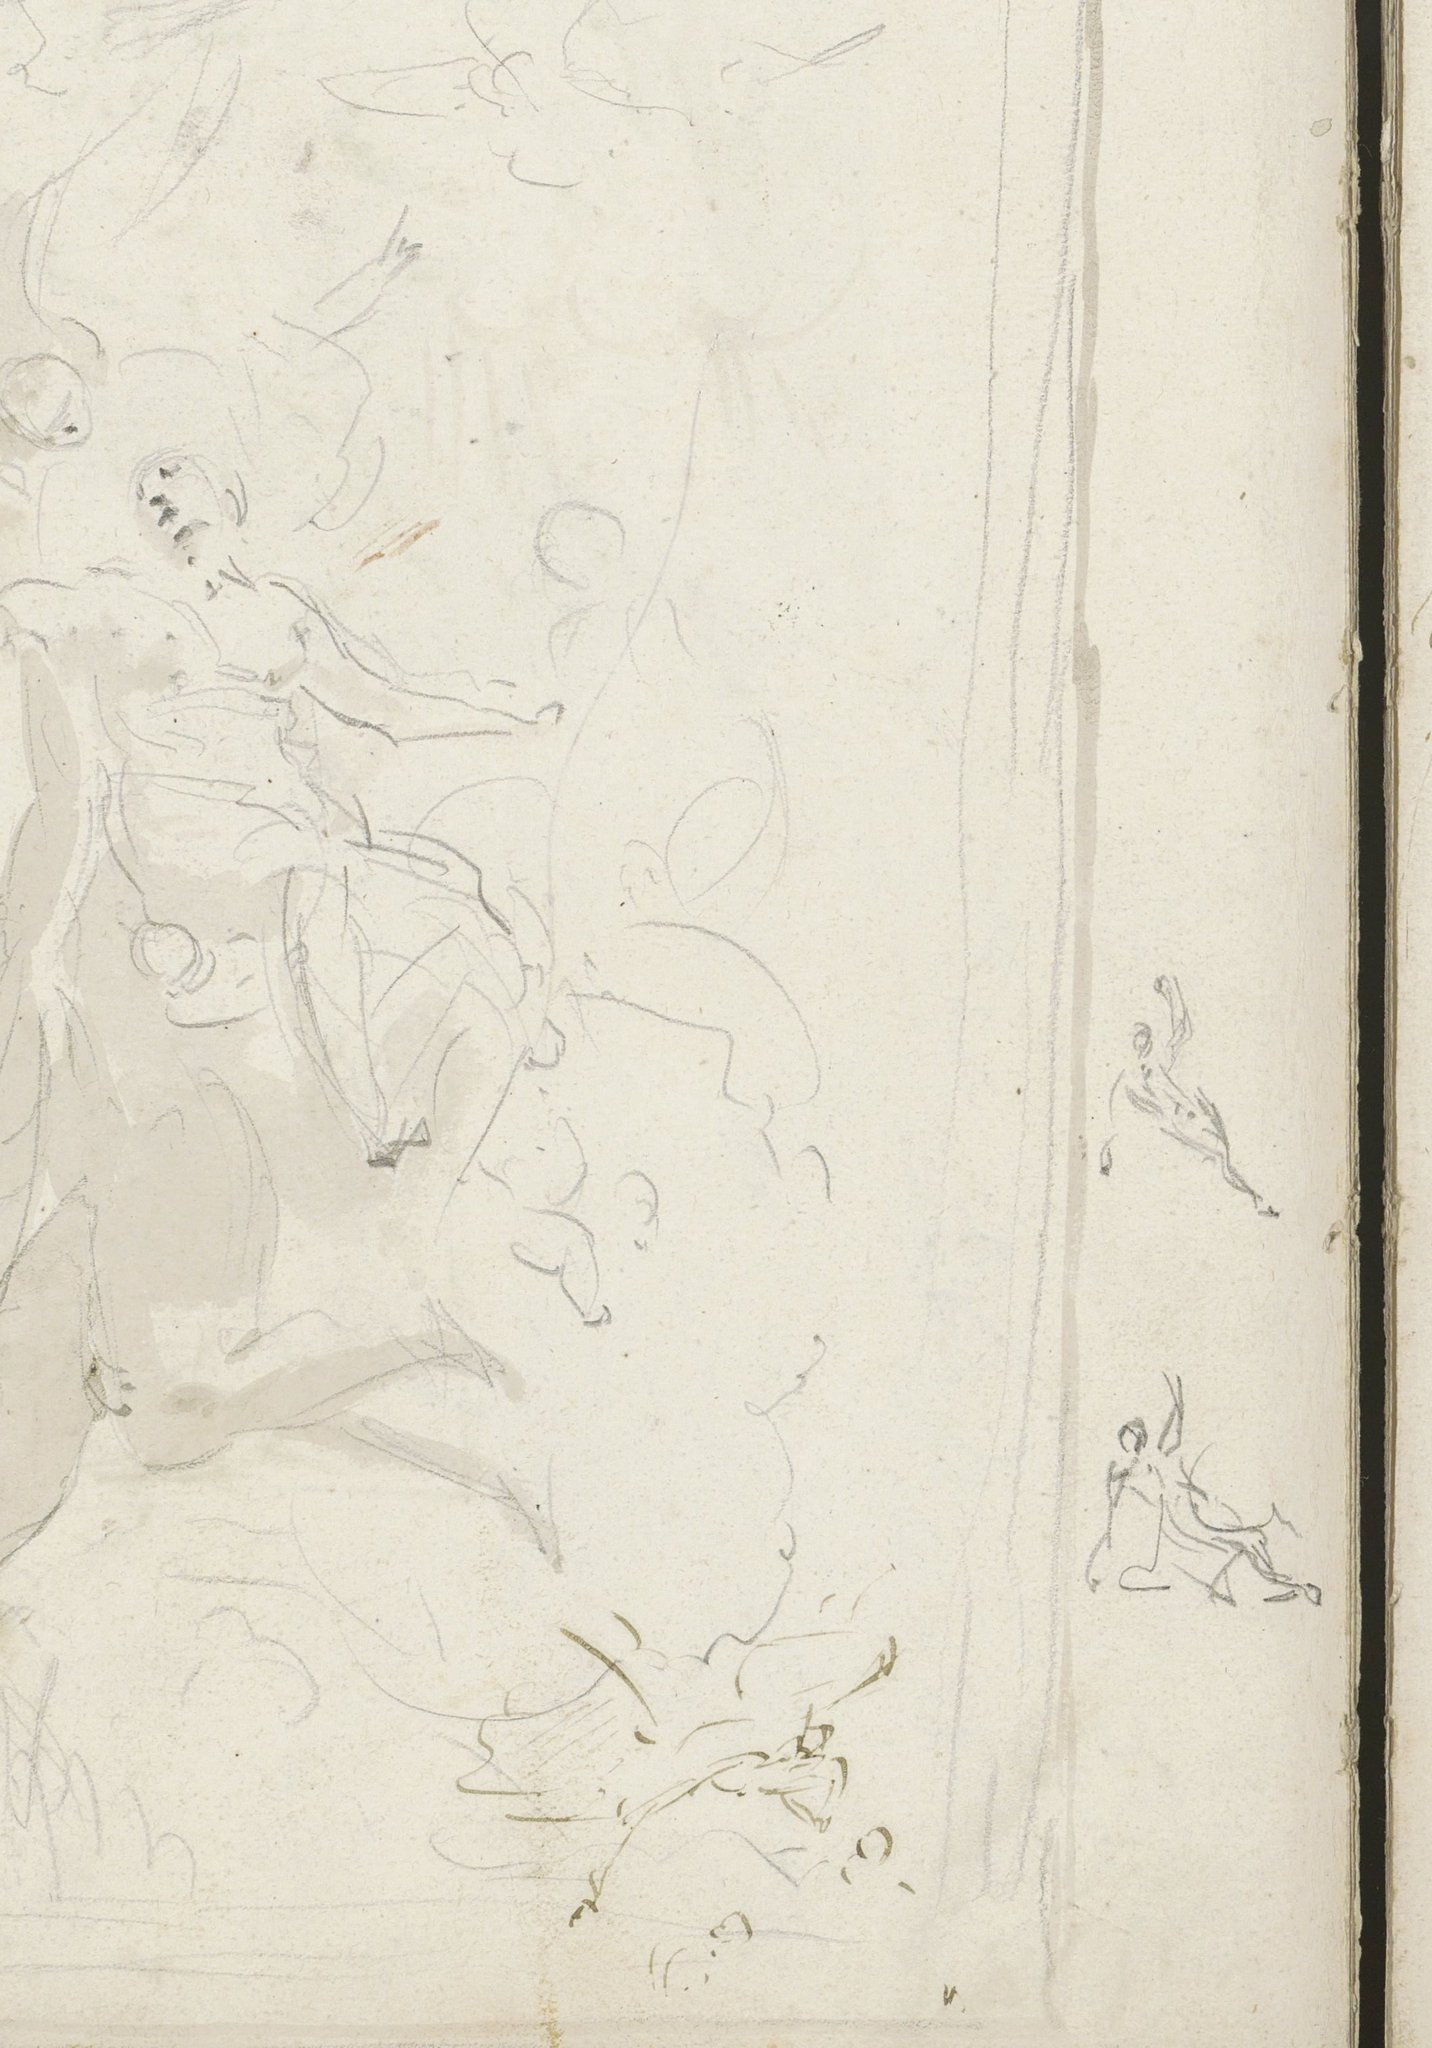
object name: sketchbook leaf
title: Allegorische voorstelling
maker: Anonymous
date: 1650-1799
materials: ink, paper, pencil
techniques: brush, pen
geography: italy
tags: anatomy (non-medical), caduceus (staff with two snakes, attribute of mercury)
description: Allegorische voorstelling met een figuur die vermoedelijk ten hemel wordt gevoerd in het gezelschap van een vrouw met een caduceus (een door twee slangen omwonden staf). Bladzijde 42 uit een schetsboek met 72 bladzijden.